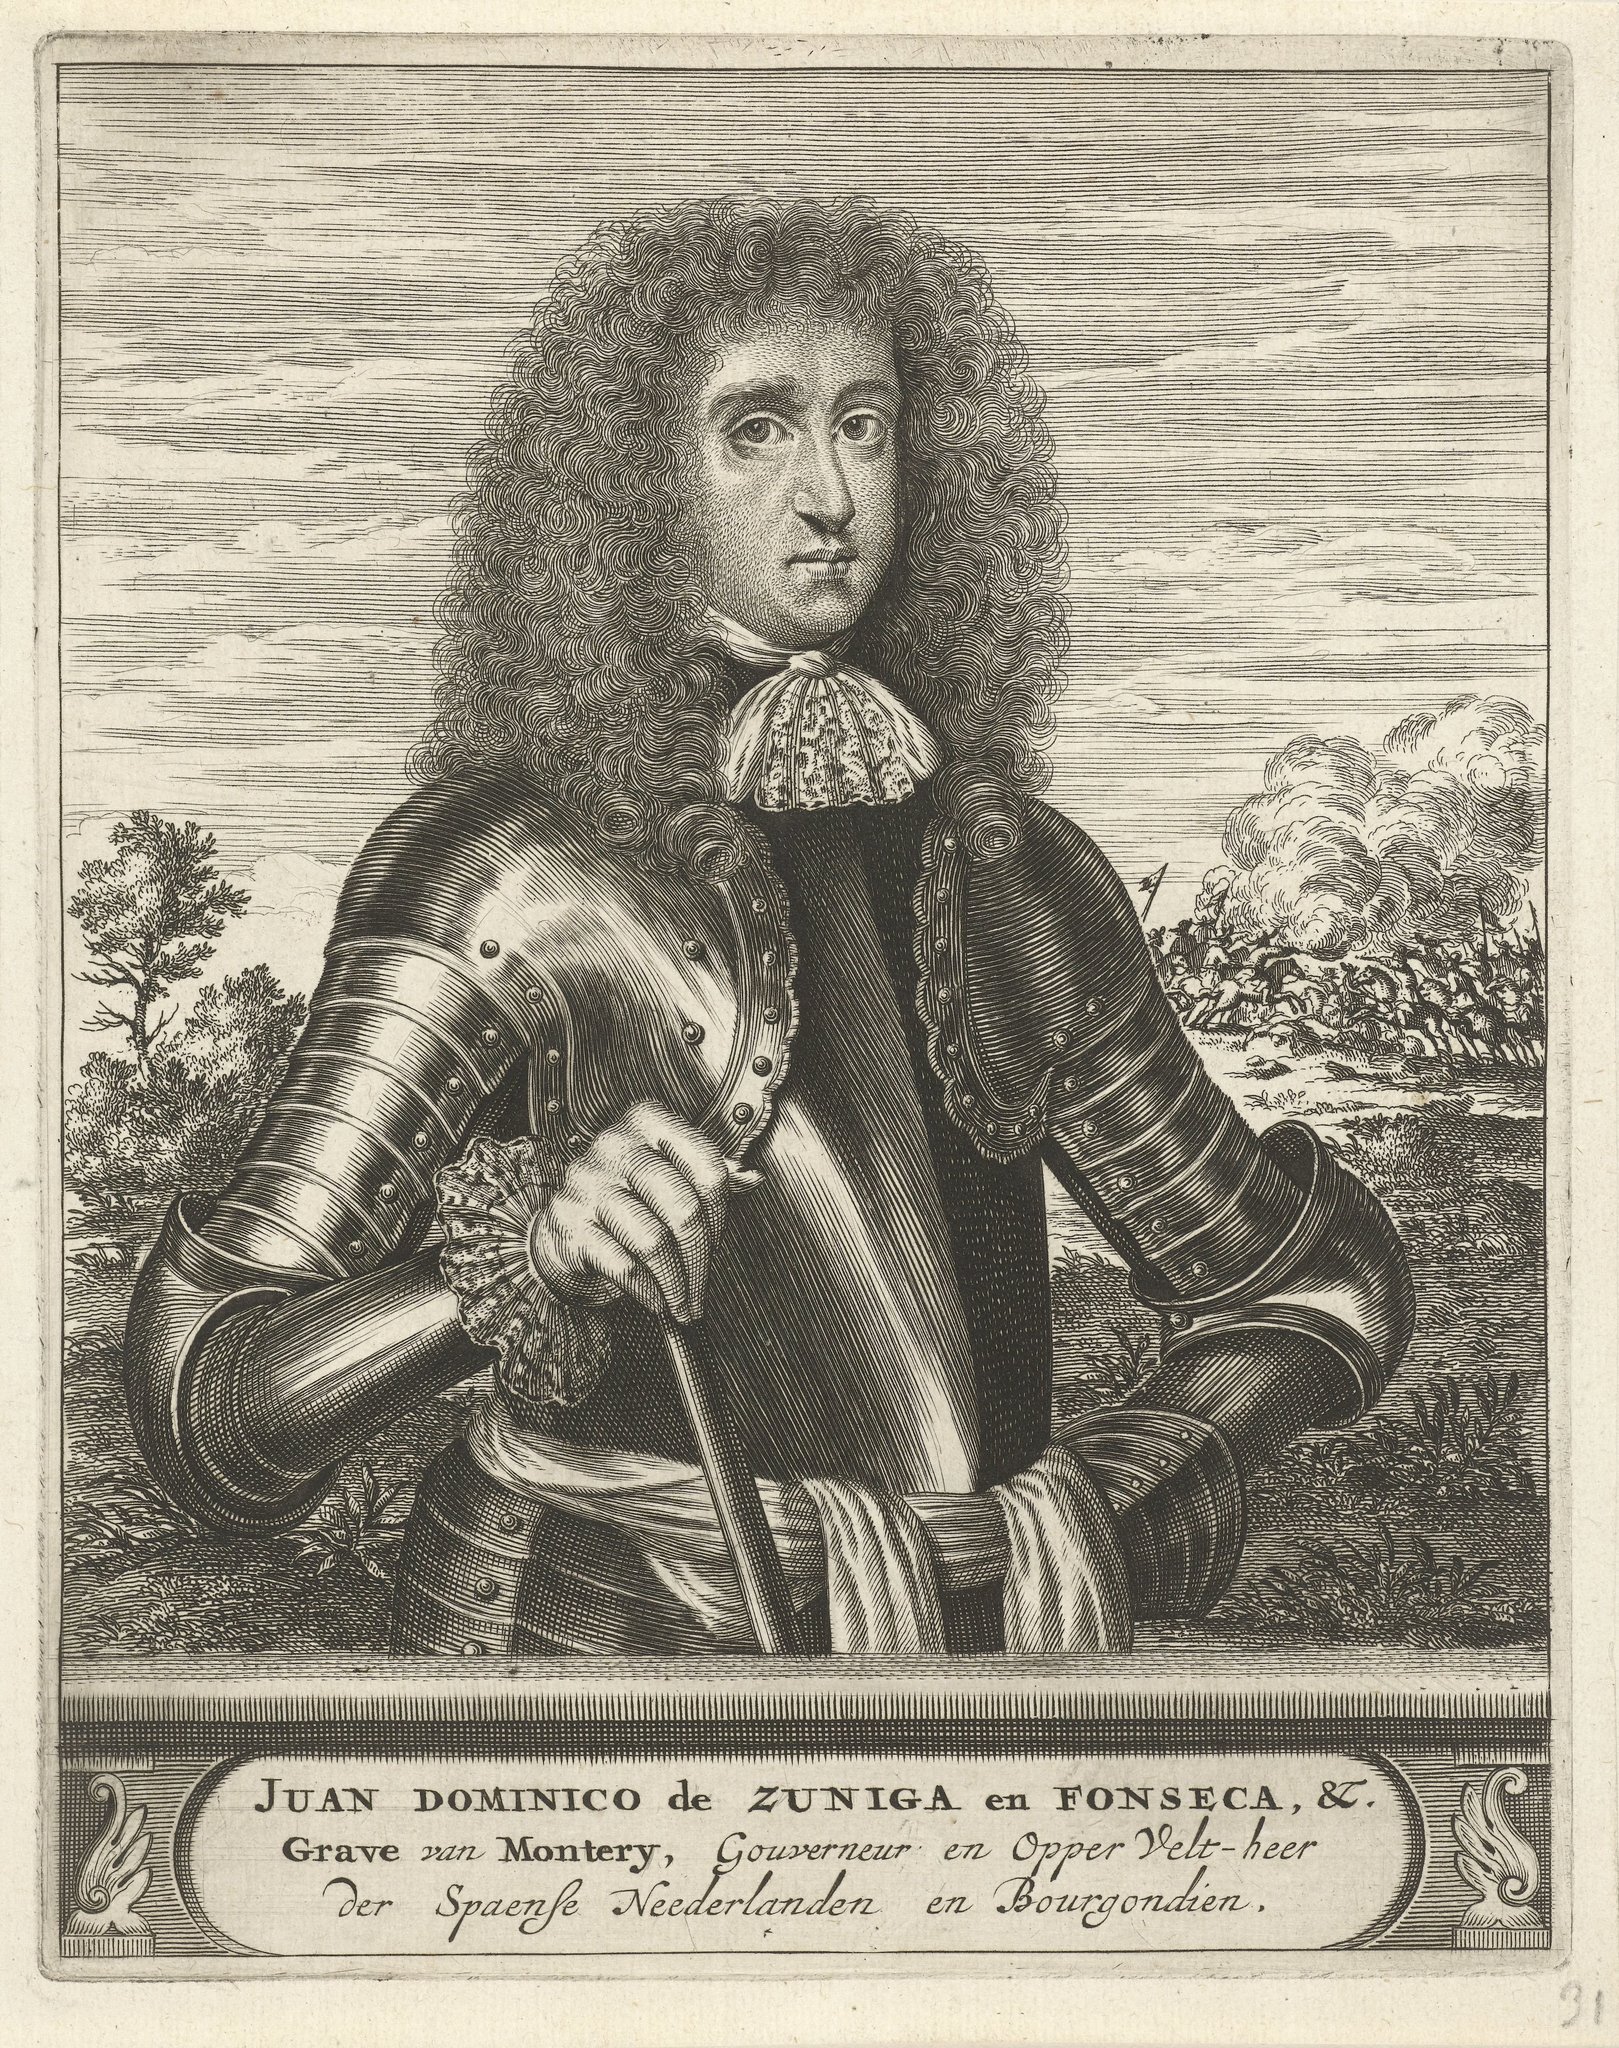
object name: print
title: Portret van Juan Domingo de Zuñiga y Fonseca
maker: christiaan hagen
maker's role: draughtsman, print maker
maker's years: 1635-1707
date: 1663-1695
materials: paper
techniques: engraving, etching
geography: amsterdam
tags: juan domingo méndez de haro y fernández de córdoba, belt, girdle, waistband, armour, battle, shoulder-belt, bandoleer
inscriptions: collector's mark: Lugt 2228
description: Portret ten halven lijve naar rechts van Juan Domingo de Zuñiga y Fonseca, gekleed in een harnas. Zijn rechterhand rust op een commandostaf. Op de achtergrond is een veldslag afgebeeld. Onder zijn portret een plint, waarop zijn naam en titel in drie regels in een cartouche.